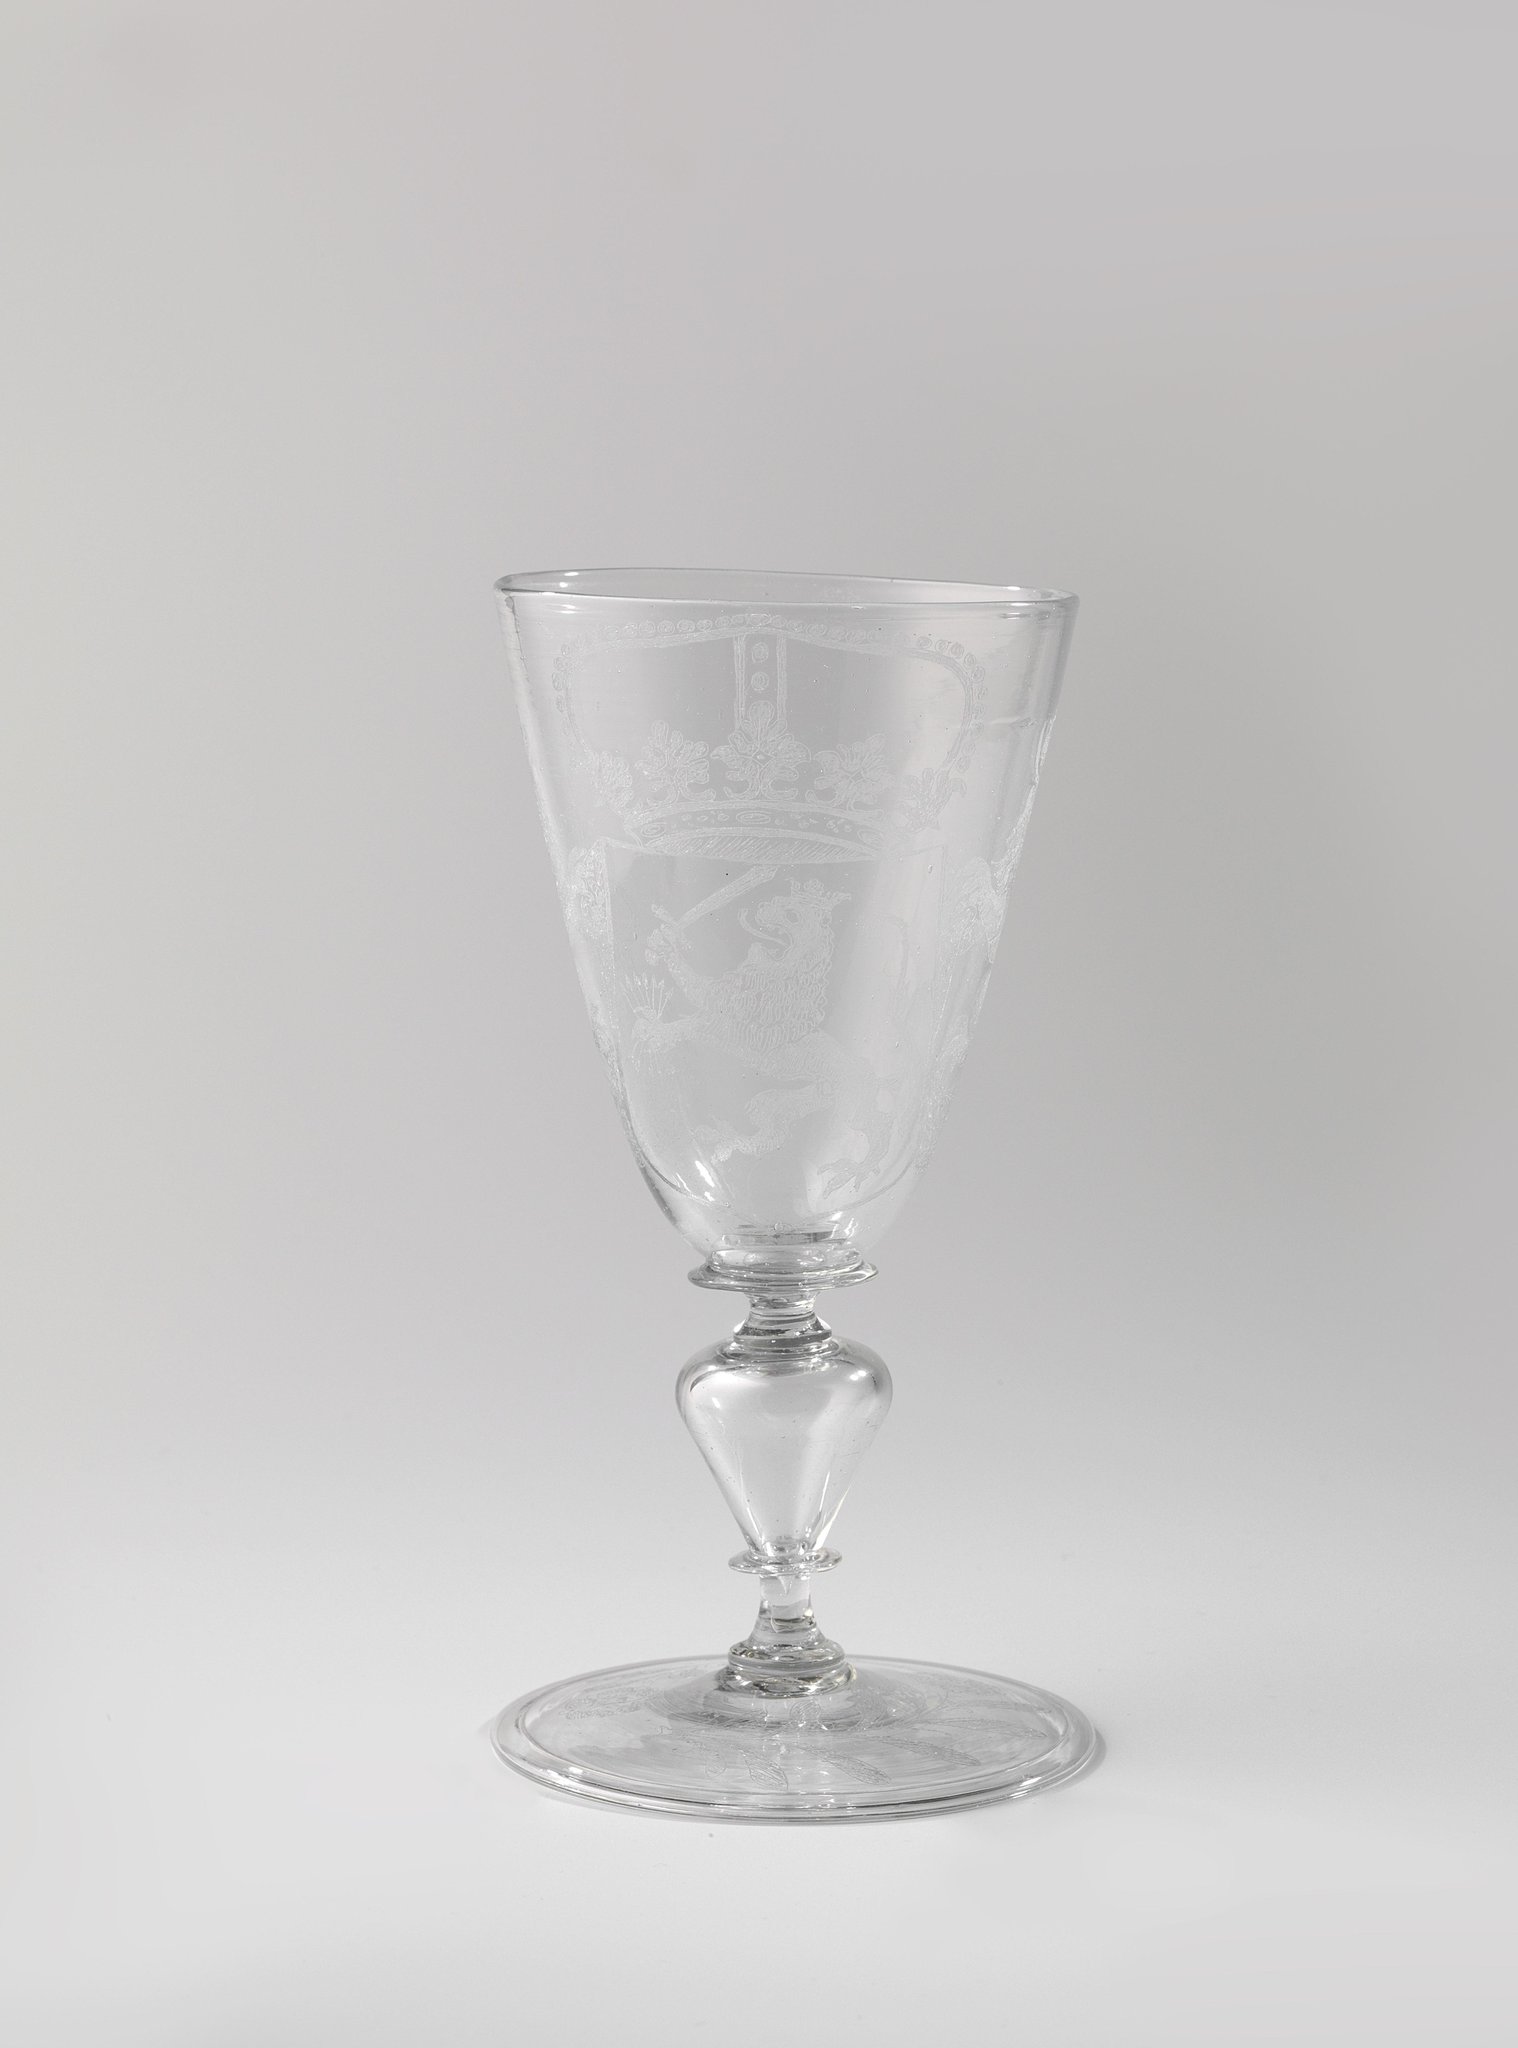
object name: goblet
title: Kelkglas met het wapen van Holland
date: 1675-1700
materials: glass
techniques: diamond point engraving, façon de venise, glassblowing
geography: low countries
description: Platte voet met omgeslagen rand en pontilmerk. Holle, balustervormige stam met twee schijven. Trechtervormige kelk. Op de kelk is het gekroonde wapen van Holland, gedragen door twee staande leeuwen gegraveerd. Op de keerzijde, juist onder de rand, is een klein vogeltje afgebeeld. Op de voet zijn twee ranken met een roos gegraveerd.